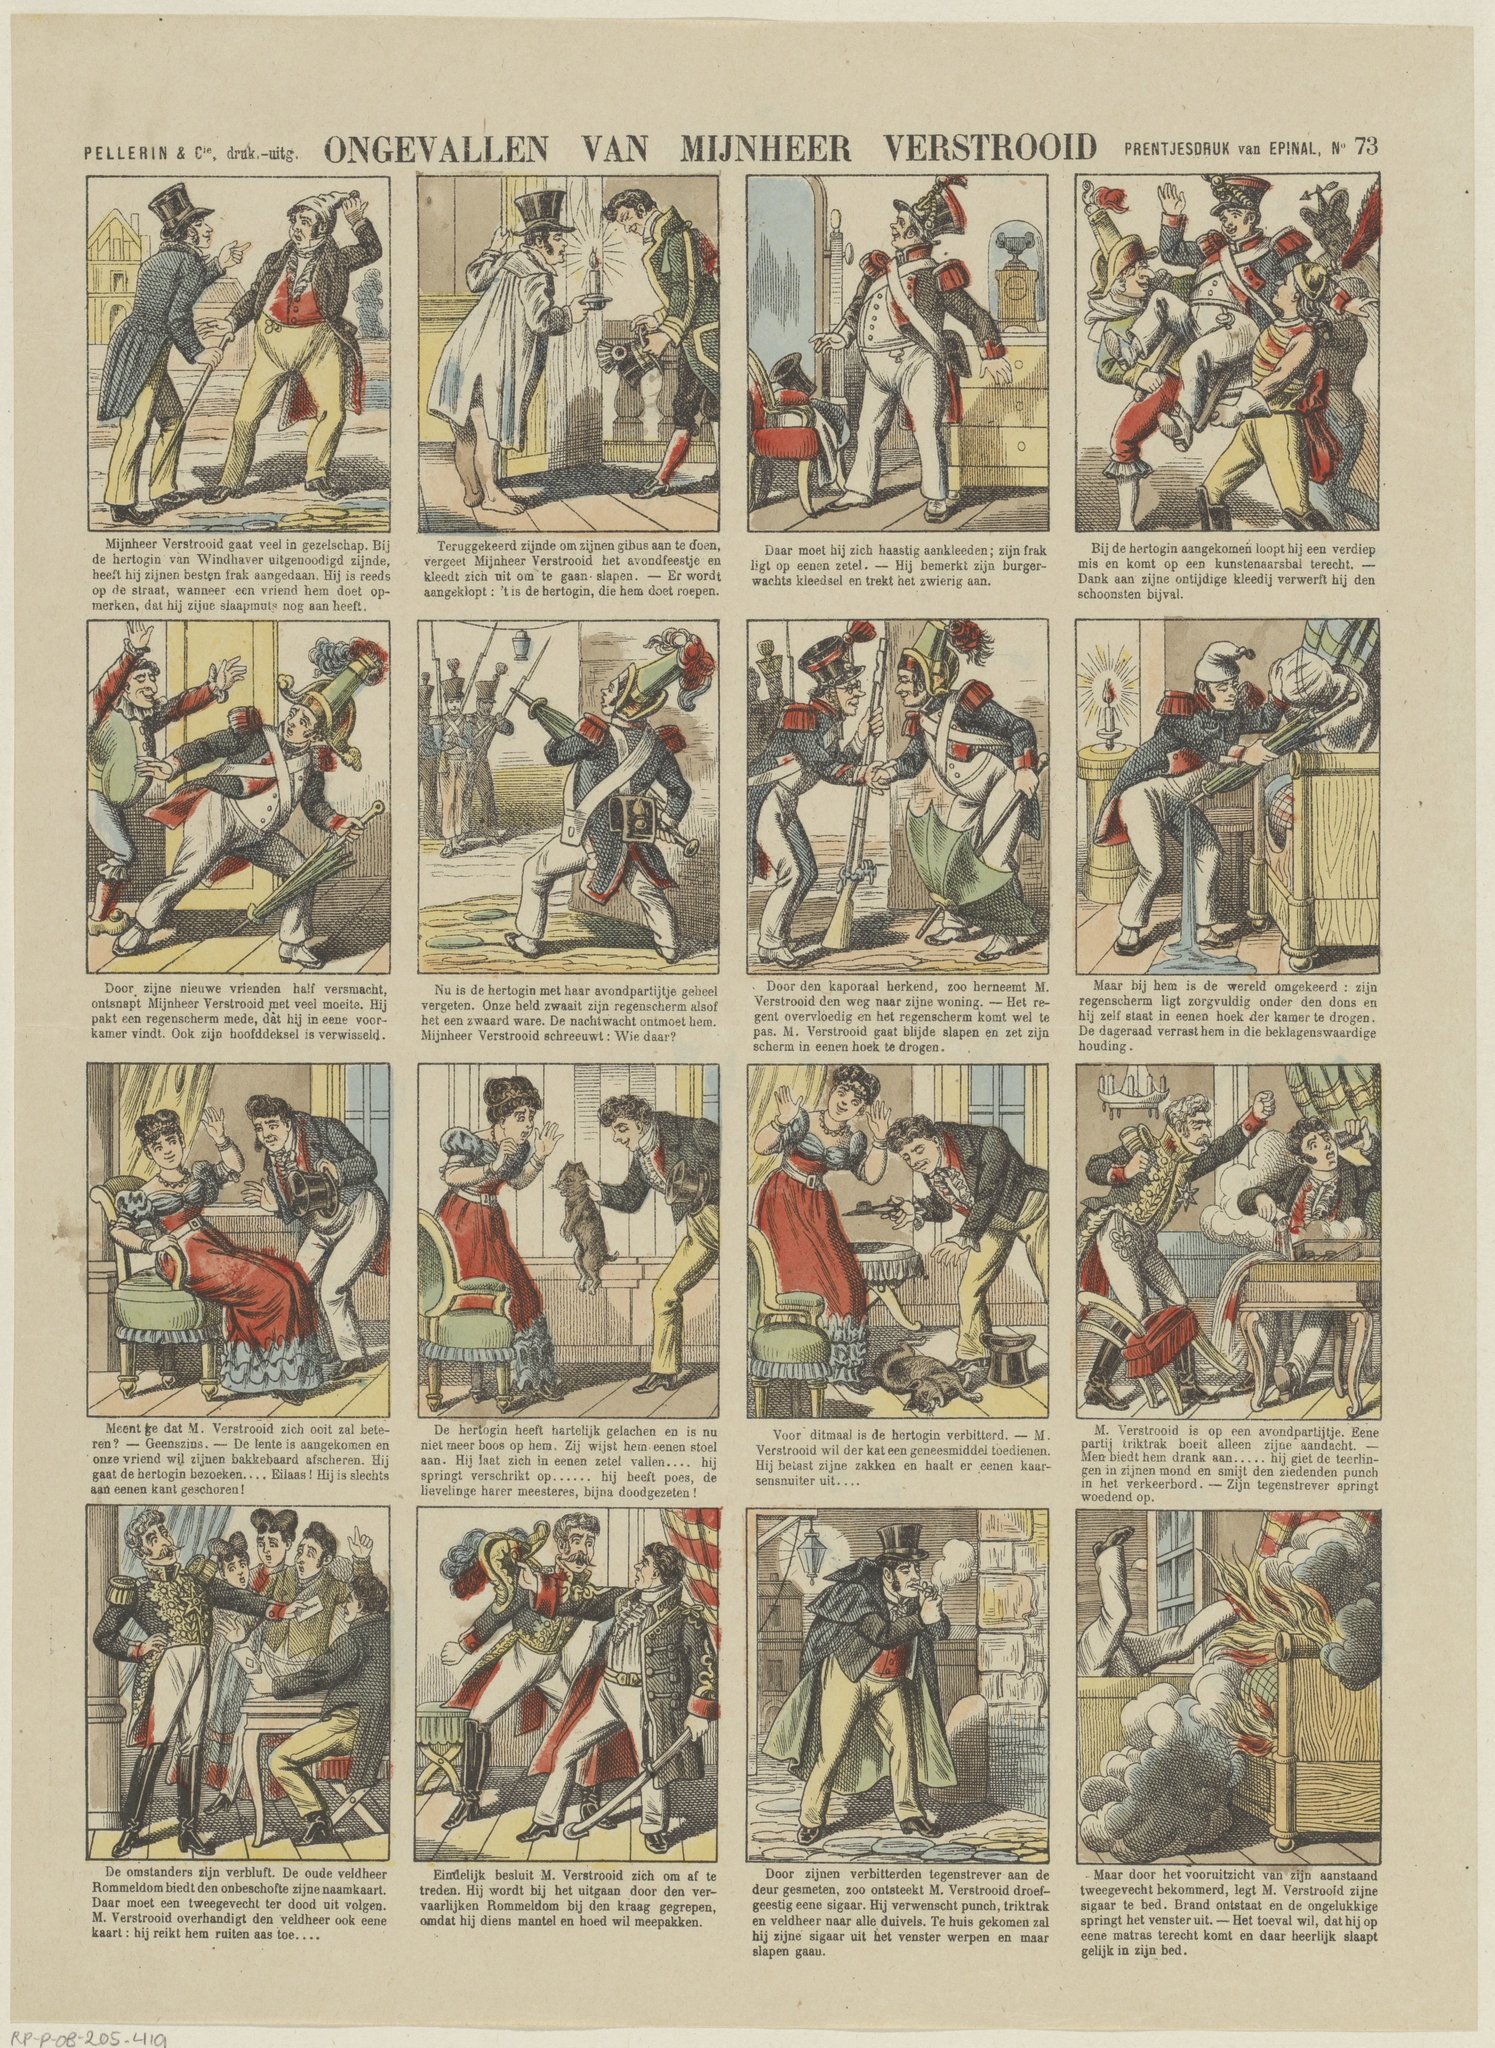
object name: print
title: Prentjesdruk van Épinal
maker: Anonymous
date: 1902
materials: paper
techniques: colour, letterpress printing, lithograph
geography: epinal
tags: absent-mindedness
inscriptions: collector's mark: Lugt 2760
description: Blad met 16 voorstellingen over een verstrooide man. Onder elke afbeelding een onderschrift. Genummerd rechtsboven: No 73.